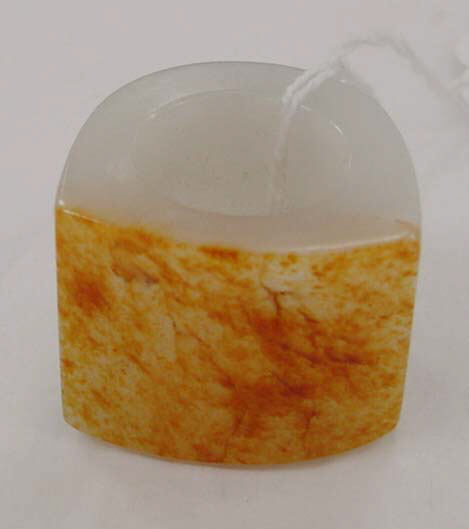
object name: ring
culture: chinese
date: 1801-1900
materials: jade